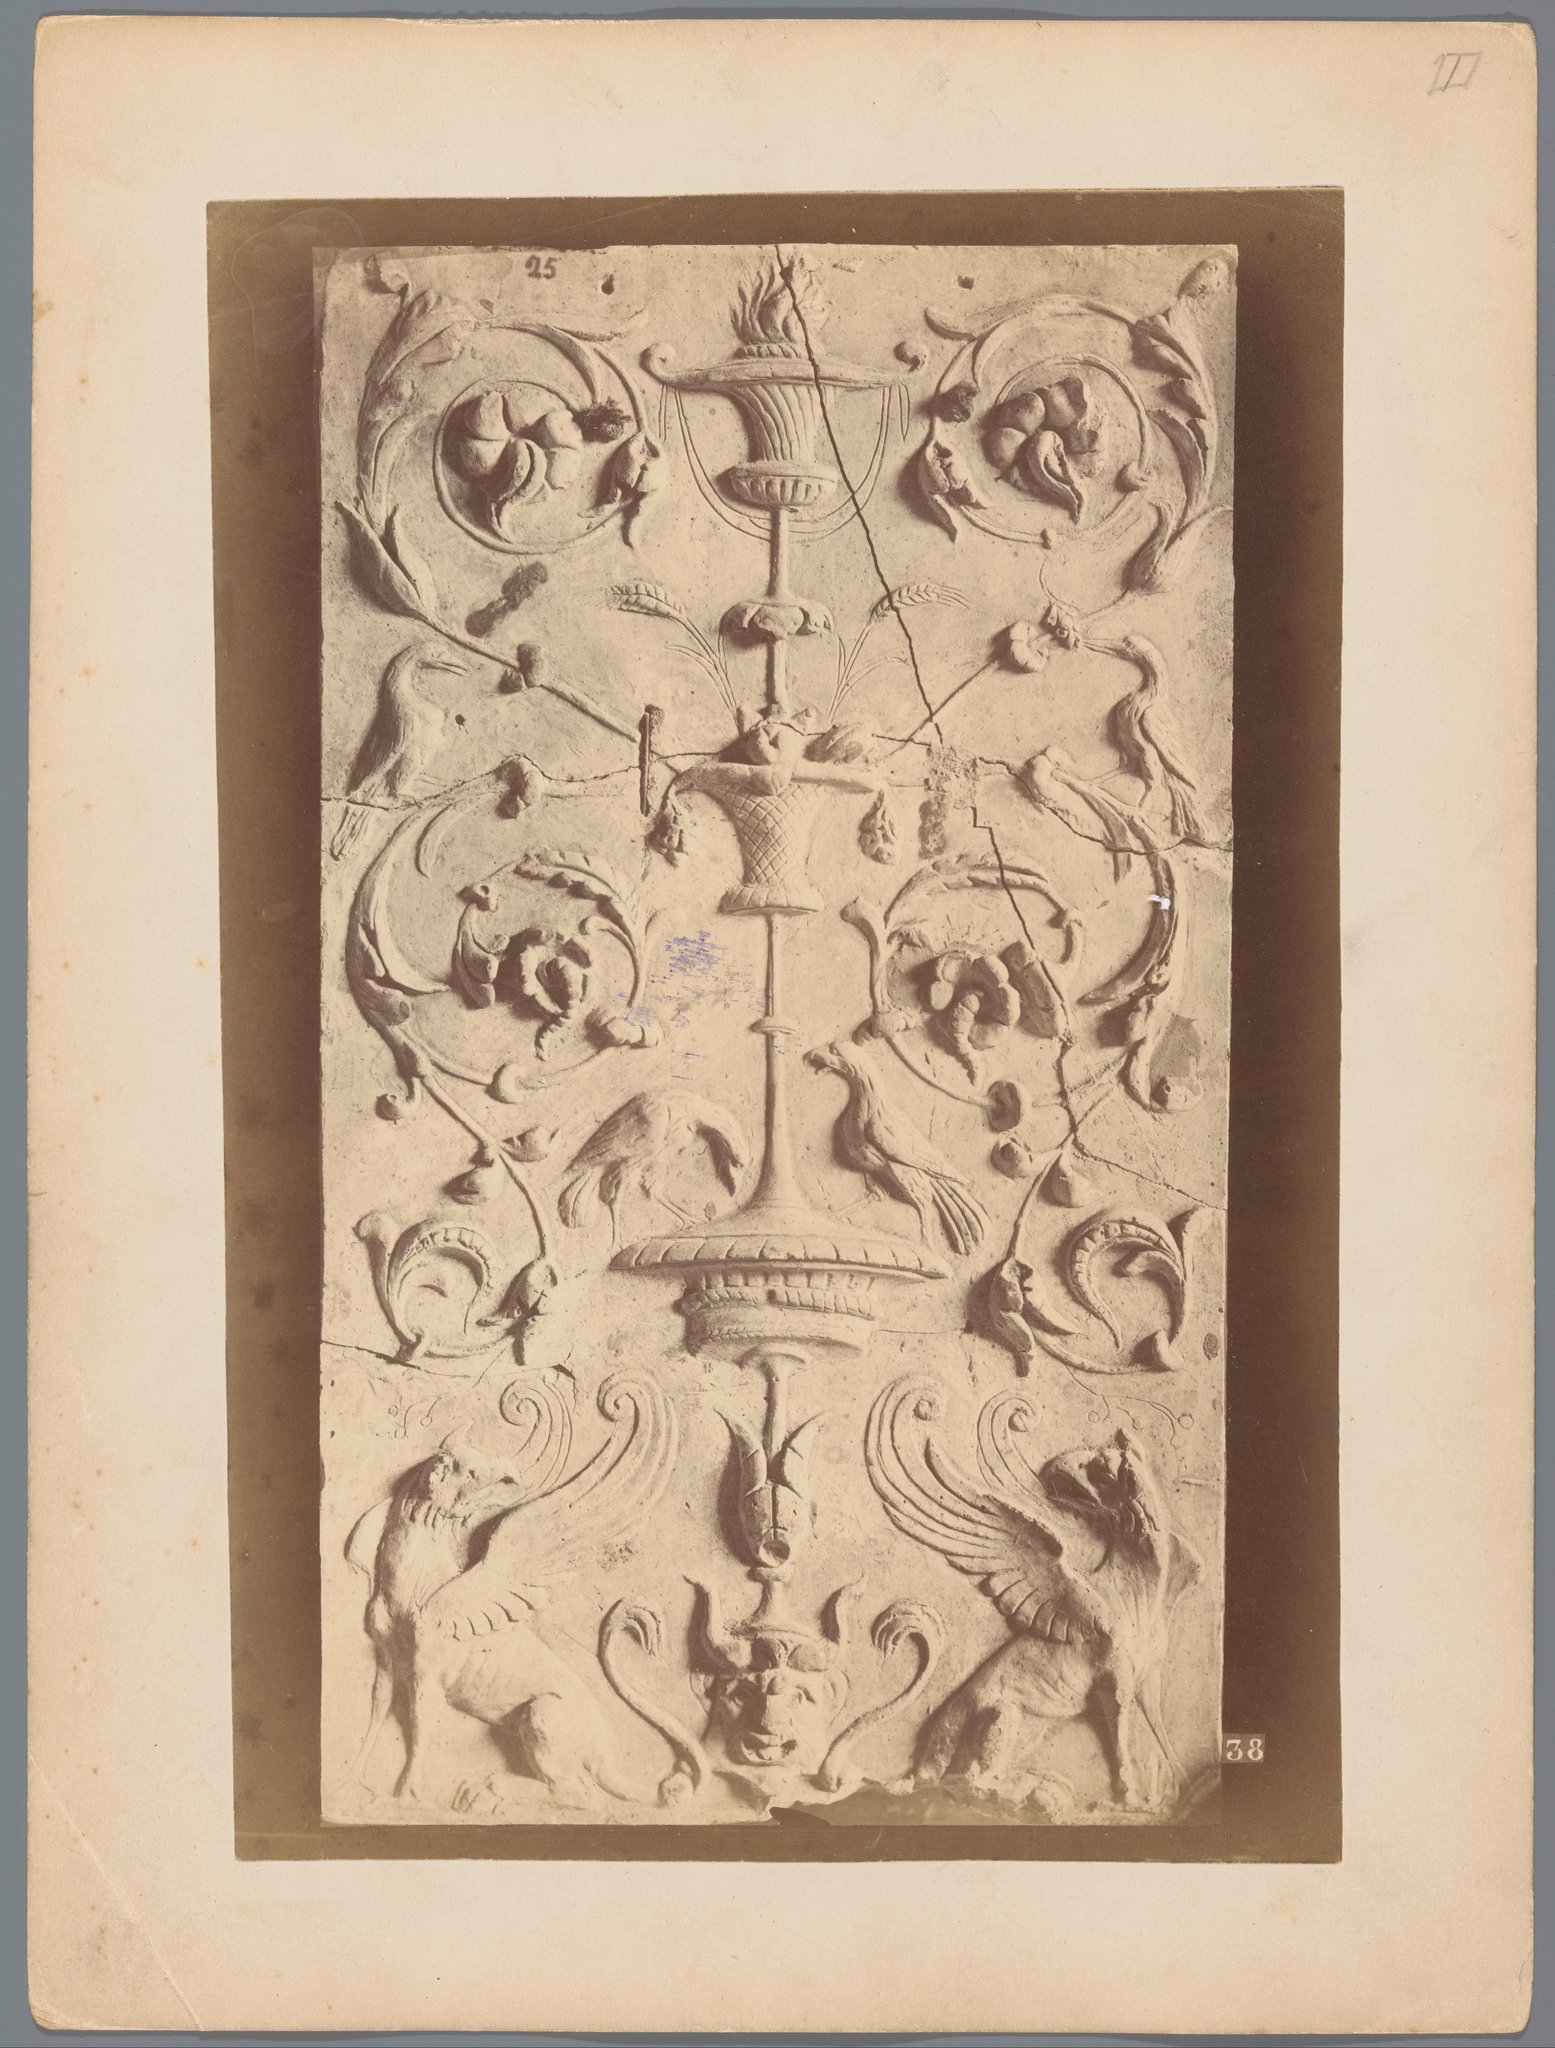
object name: photograph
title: Reliëf met arabesken, vogels en twee griffioenen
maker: Anonymous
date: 1875-1900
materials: cardboard, photographic support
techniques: albumen print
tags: griffin (lion/eagle); 'griffo' (ripa), ornamental birds, ornament ~ arabesque, sculpture (+ relief ~ sculpture)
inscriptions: number: ‘38’, collector's mark: Lugt 3937